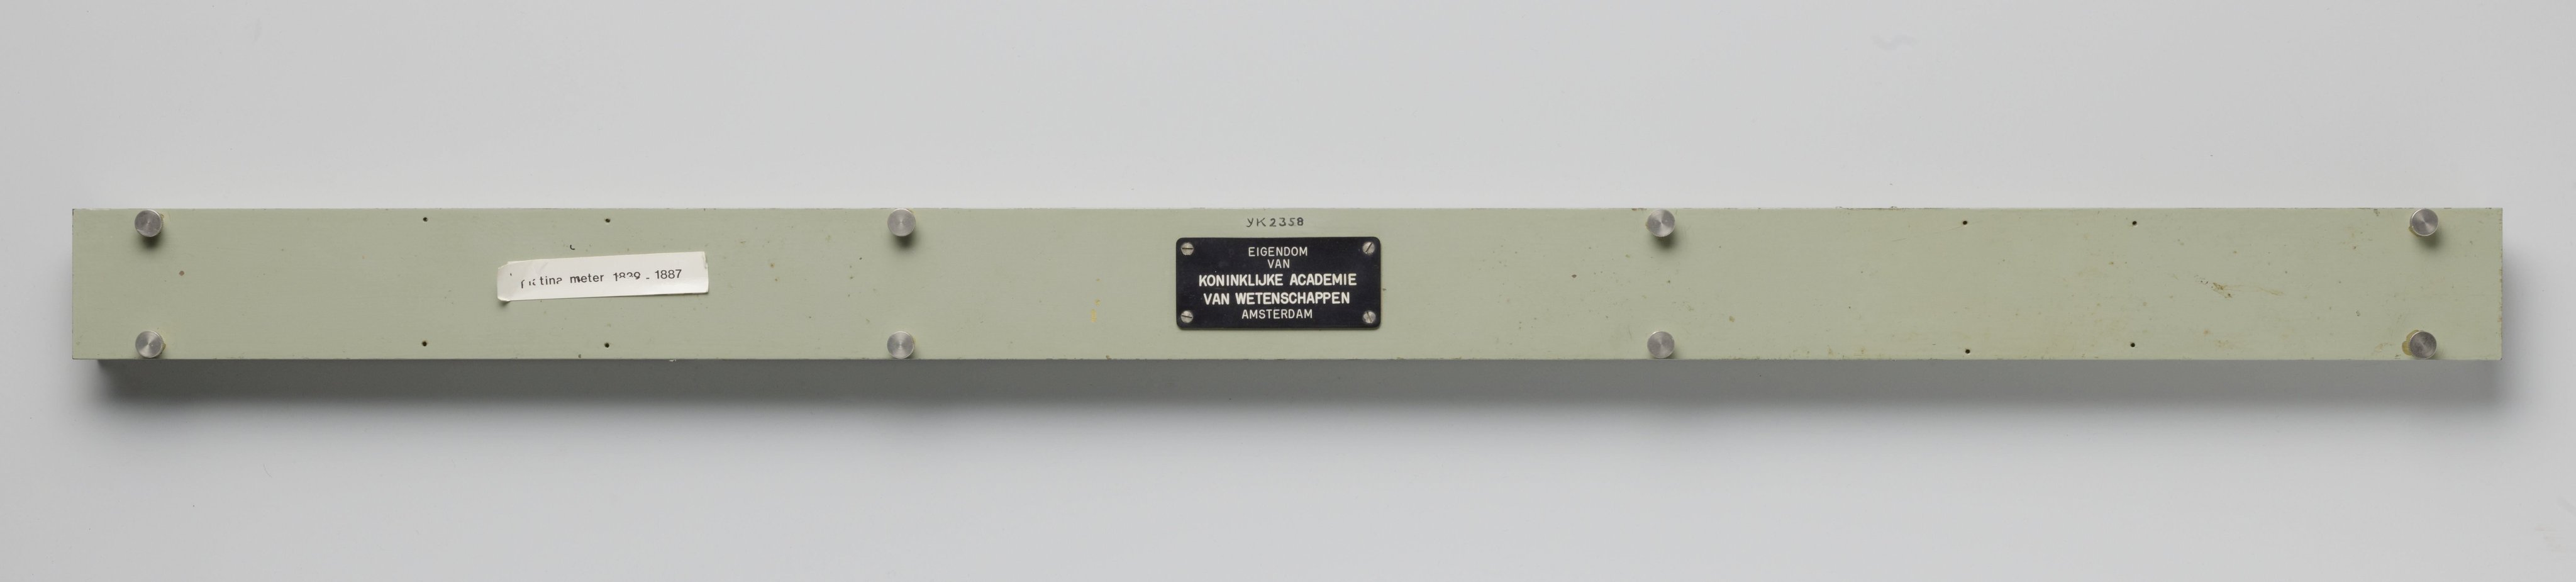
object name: case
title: Platina standaardmeter uit 1839 met koperen plaat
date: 1839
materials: copper, cork, platinum, wood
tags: maastricht, engineer, antoine lipkens, amsterdam, netherlands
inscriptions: inscription: ‘PLATINA METER Een commissie bestaande uit de heren Lipkens, Lobatto en Prof. Uylenbroek heeft in 1838 de opdracht gekregen in Parijs een nieuwe nationale standaard van de meter en het kilogram te vervaardigen. De standaard van lengte (platina meter) werd in 1839 de "enige standaard van de Nederlandse El" en in bewaring gegeven bij het Konkinklijk Instituut.’, inscription: ‘platina meter 1839 - 1887’, inscription: ‘EIGENDOM VAN KONINKLIJKE ACADEMIE VAN WETENSCHAPPEN AMSTERDAM’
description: Platina standaardmeter waarop aan beide zijkanten met 1 meter tussenruimte kruisen zijn gegraveerd. Meter rust op 2 houders met rolletjes in koperen, grijsgroen geverfde rechthoekige foedraal, opgevuld met 6 stukken hout en kurk. Foudraal wordt dichtgeschoefd met 8 schroeven. Op foedraal is rechthoekig eigendomsplaatje aangebracht van de Koninklijke Academie. Oorspronkelijk zat deze meter in een houten doos, waarop een koperen plaat was bevestigd (zie NG-2002-83-B).